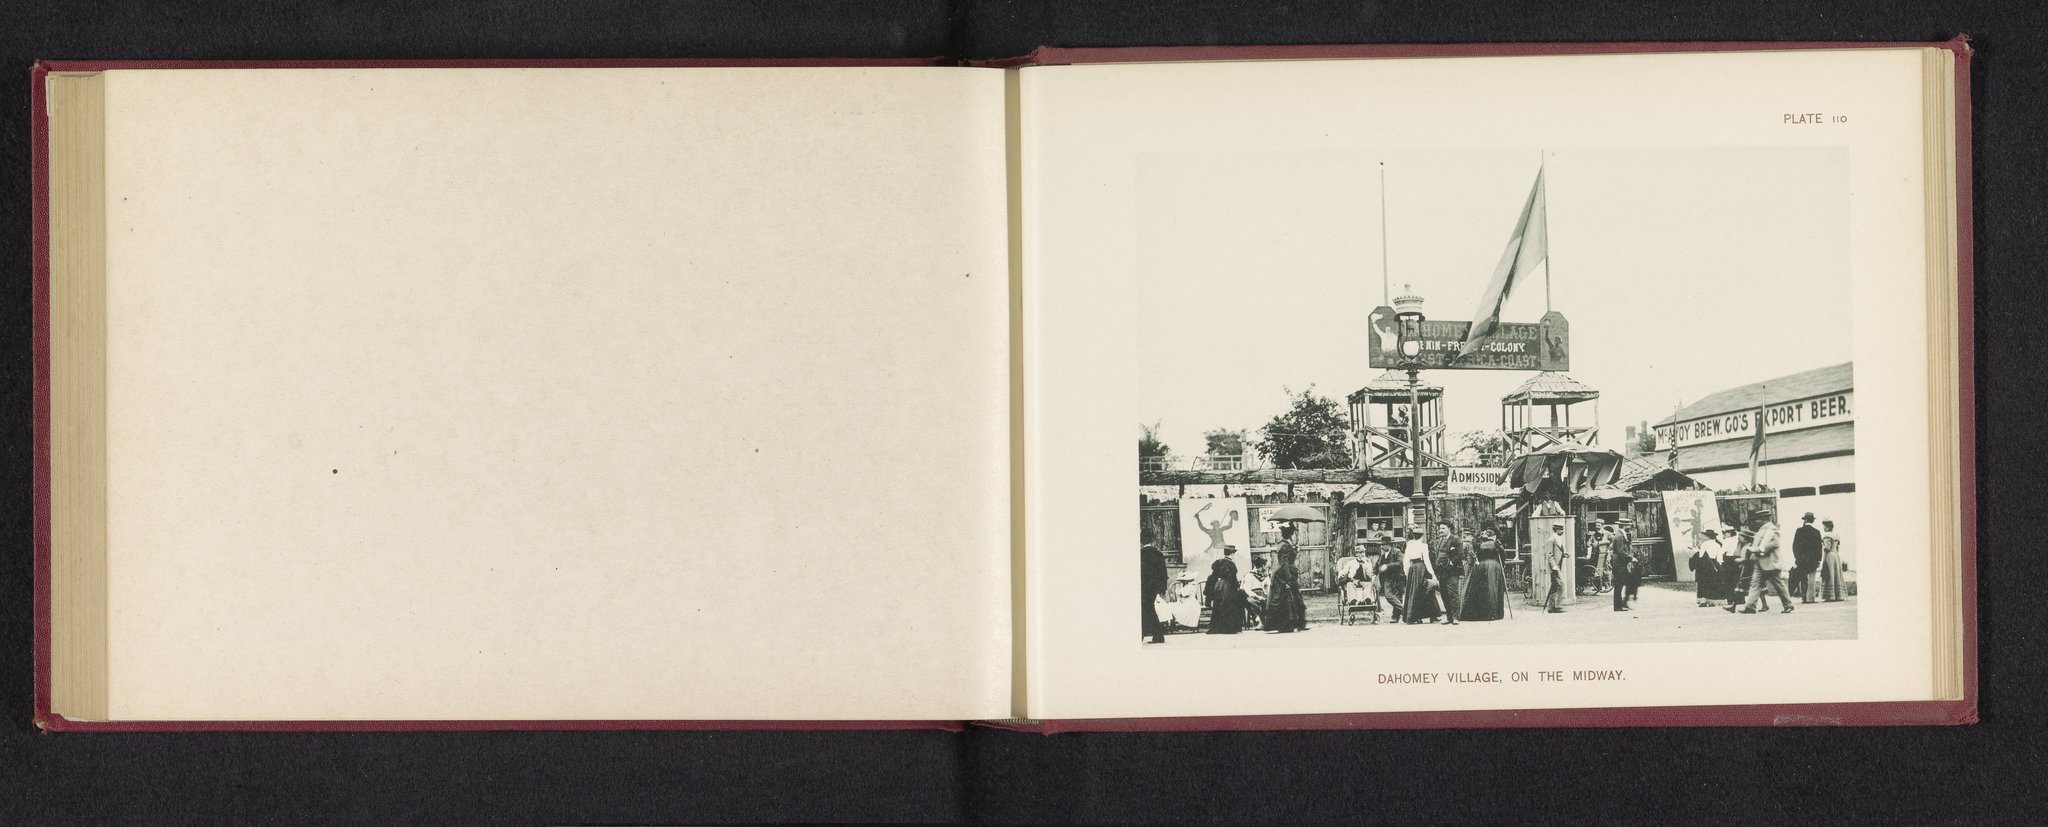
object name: photomechanical print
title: Dahomey village, on the Midway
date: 1893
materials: paper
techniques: photograph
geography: chicago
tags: world fair, world exhibition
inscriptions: number: ‘Plate 110’